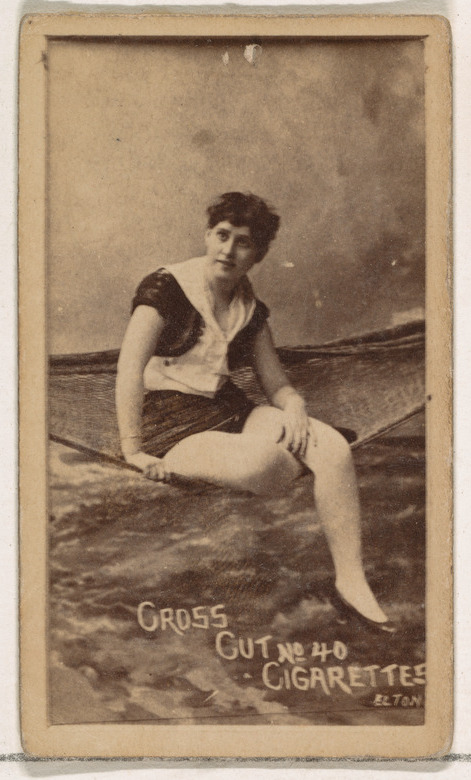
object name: print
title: Card Number 40, Elton, from the Actors and Actresses series (N145-1) issued by Duke Sons & Co. to promote Cross Cut Cigarettes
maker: w. duke, sons & co.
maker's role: publisher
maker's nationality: american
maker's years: 1870-1920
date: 1880-1889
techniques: albumen silver print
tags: portraits,women,actresses